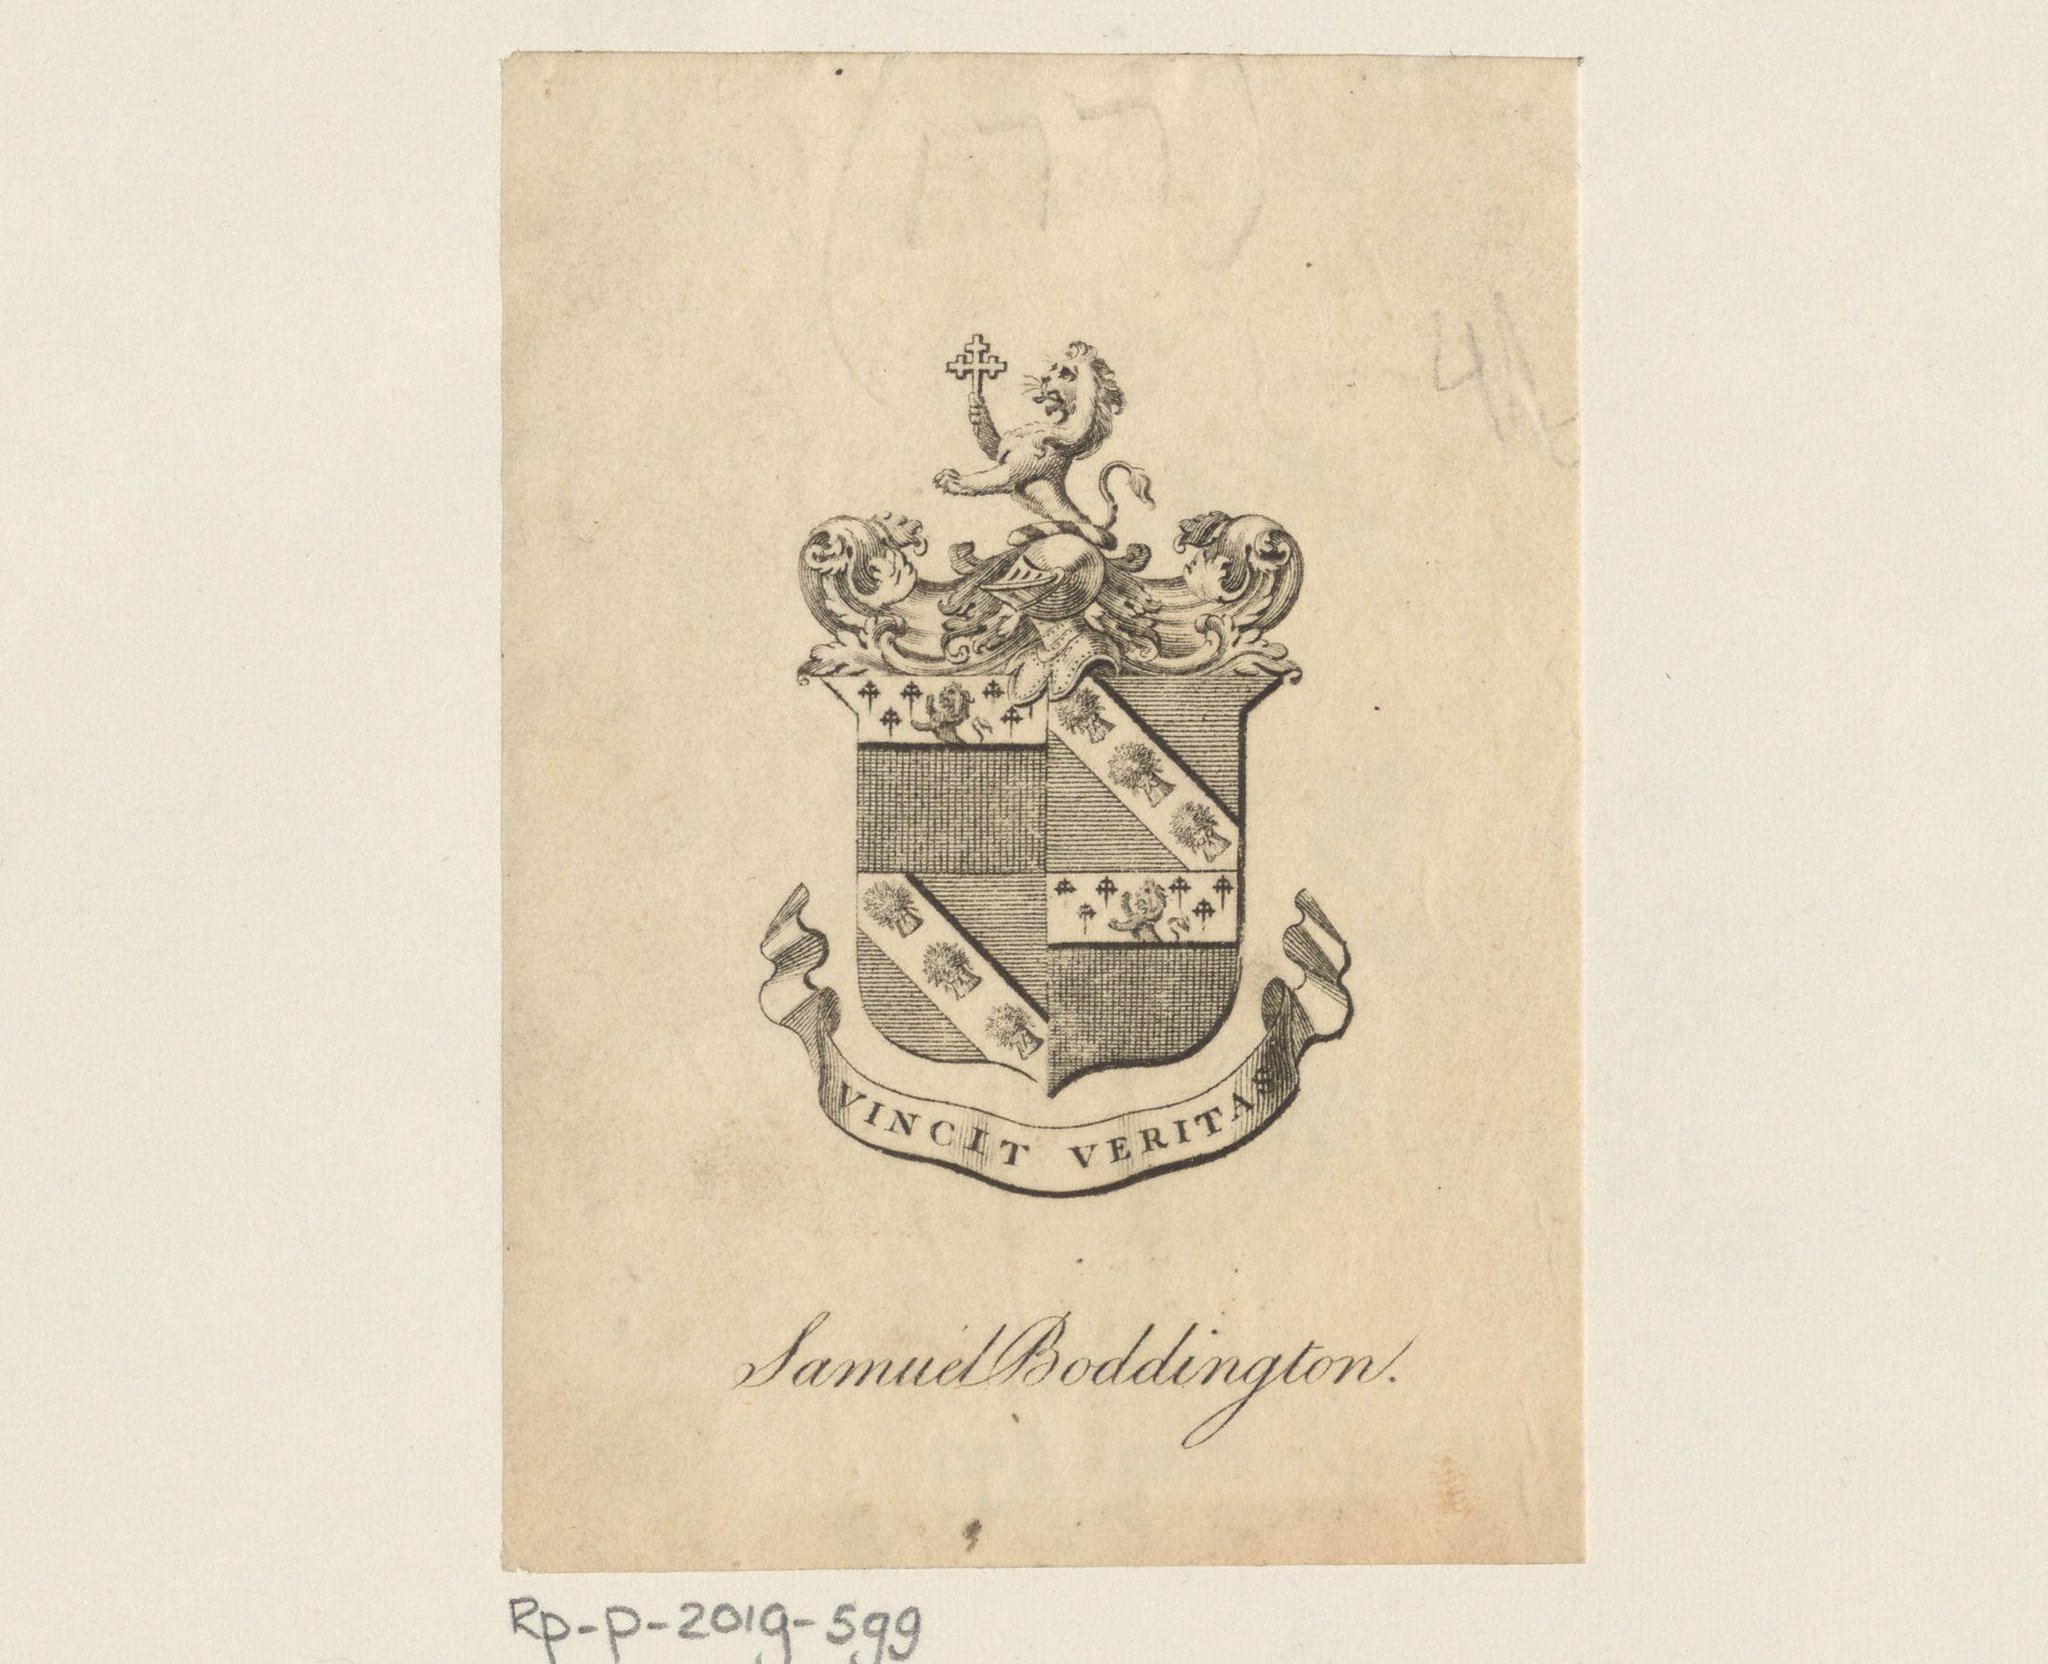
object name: bookplate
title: Vincit veritas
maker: Anonymous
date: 1776-1843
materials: paper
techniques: engraving, etching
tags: politician, study; 'studiolo'; library